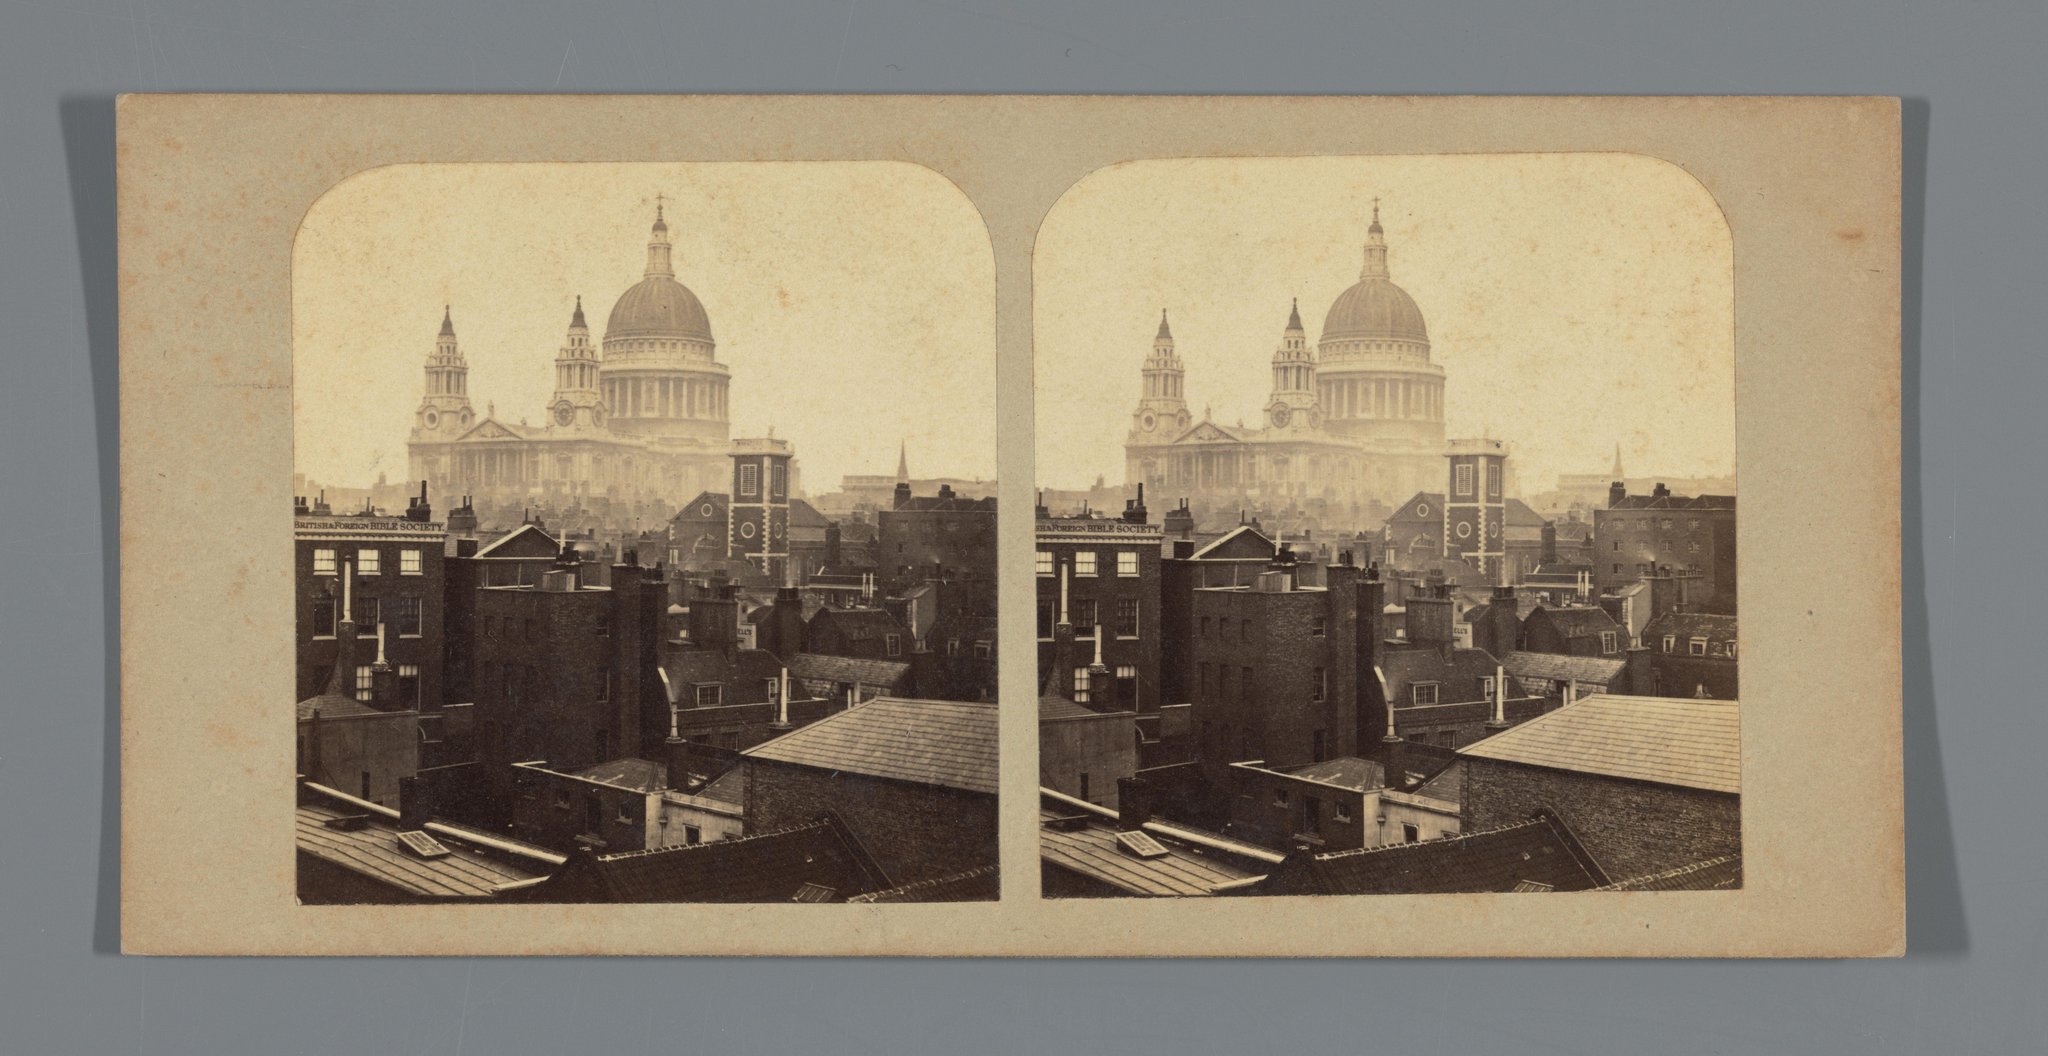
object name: stereograph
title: St. Paul’s Cathedral, from Blackfriars’ Bridge. Views of London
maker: Anonymous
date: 1860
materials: cardboard, photographic support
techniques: albumen print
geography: london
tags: church (exterior), dome ~ architecture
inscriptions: inscription: ‘hk’, number: ‘18.’